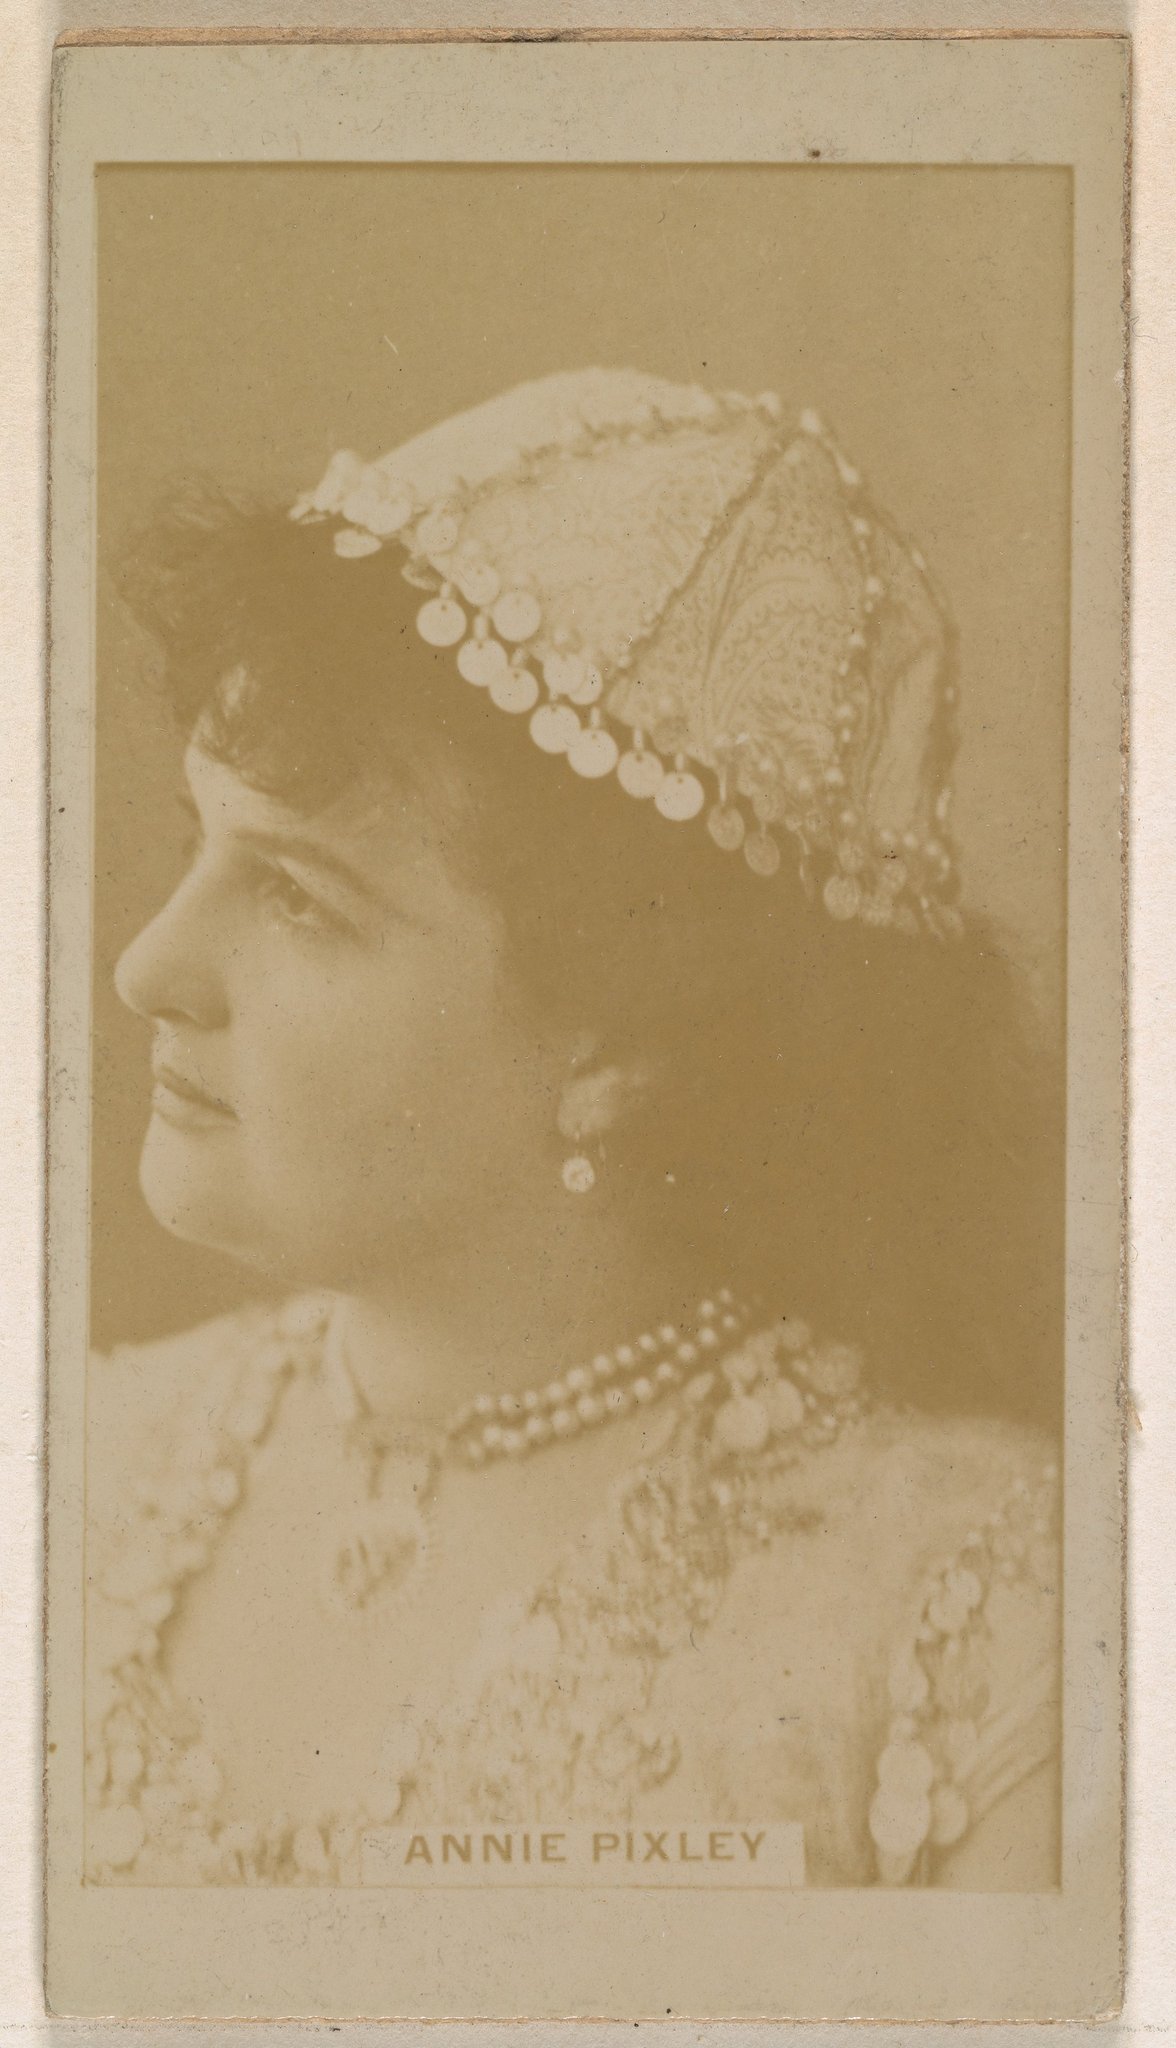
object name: photograph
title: Annie Pixley, from the Actresses series (N245) issued by Kinney Brothers to promote Sweet Caporal Cigarettes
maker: kinney brothers tobacco company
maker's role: publisher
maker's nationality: american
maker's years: 1869-2011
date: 1890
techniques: albumen silver print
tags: women,actresses